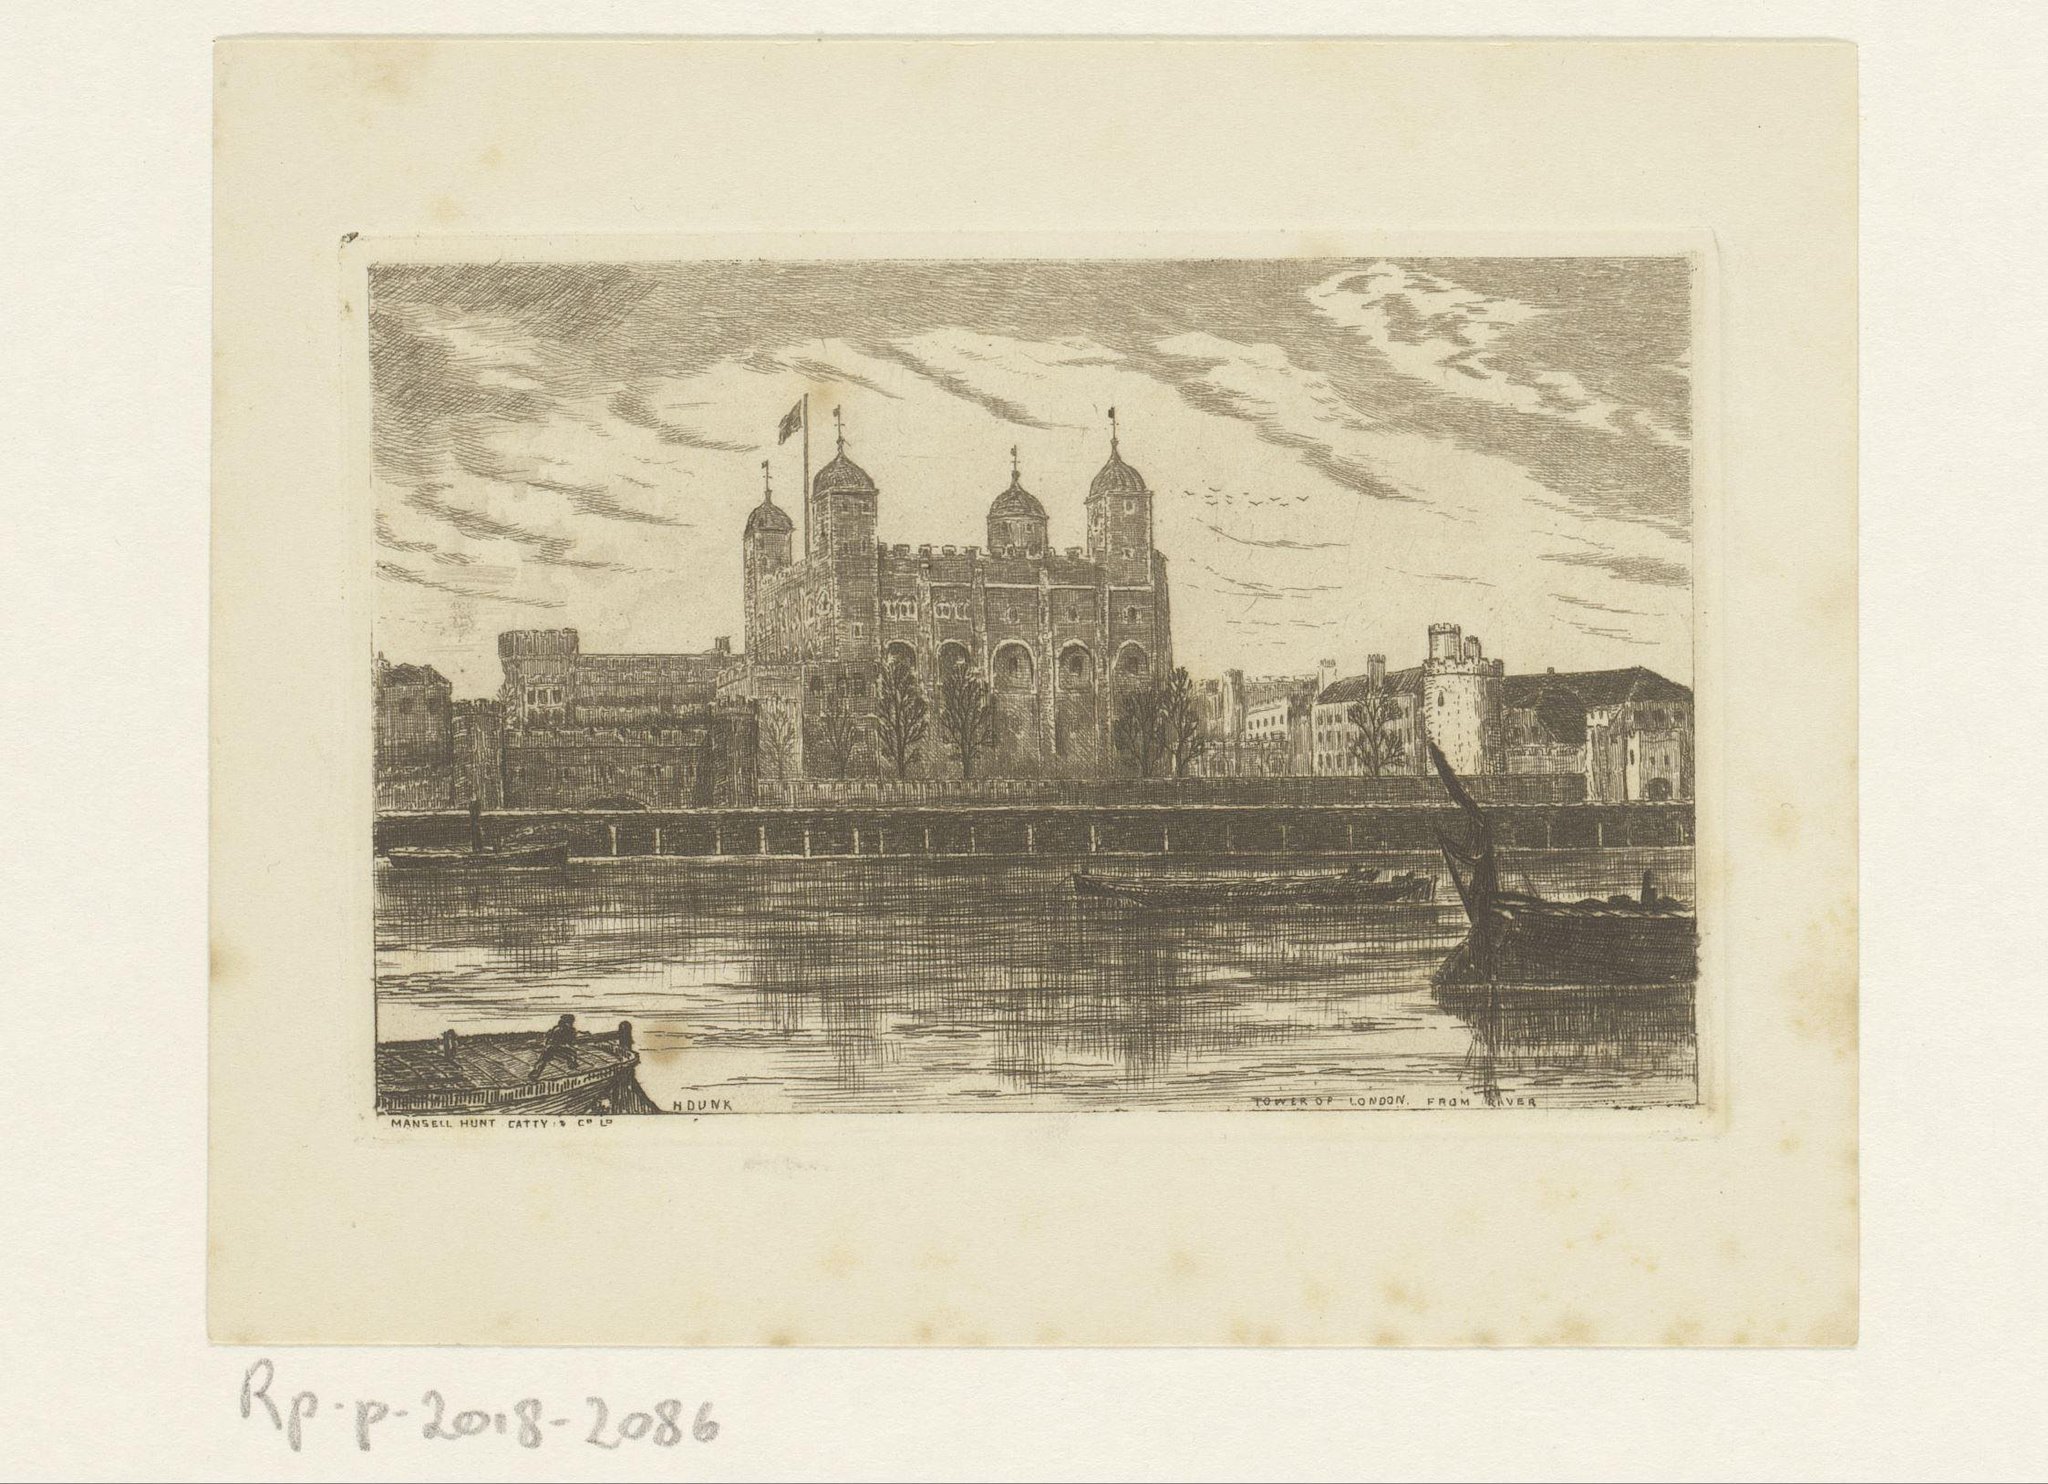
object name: print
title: Gezicht op de Tower of London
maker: Anonymous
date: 1850-1949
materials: paper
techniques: etching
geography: london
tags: fortress, tower (of house or building)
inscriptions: collector's mark: Lugt 2228